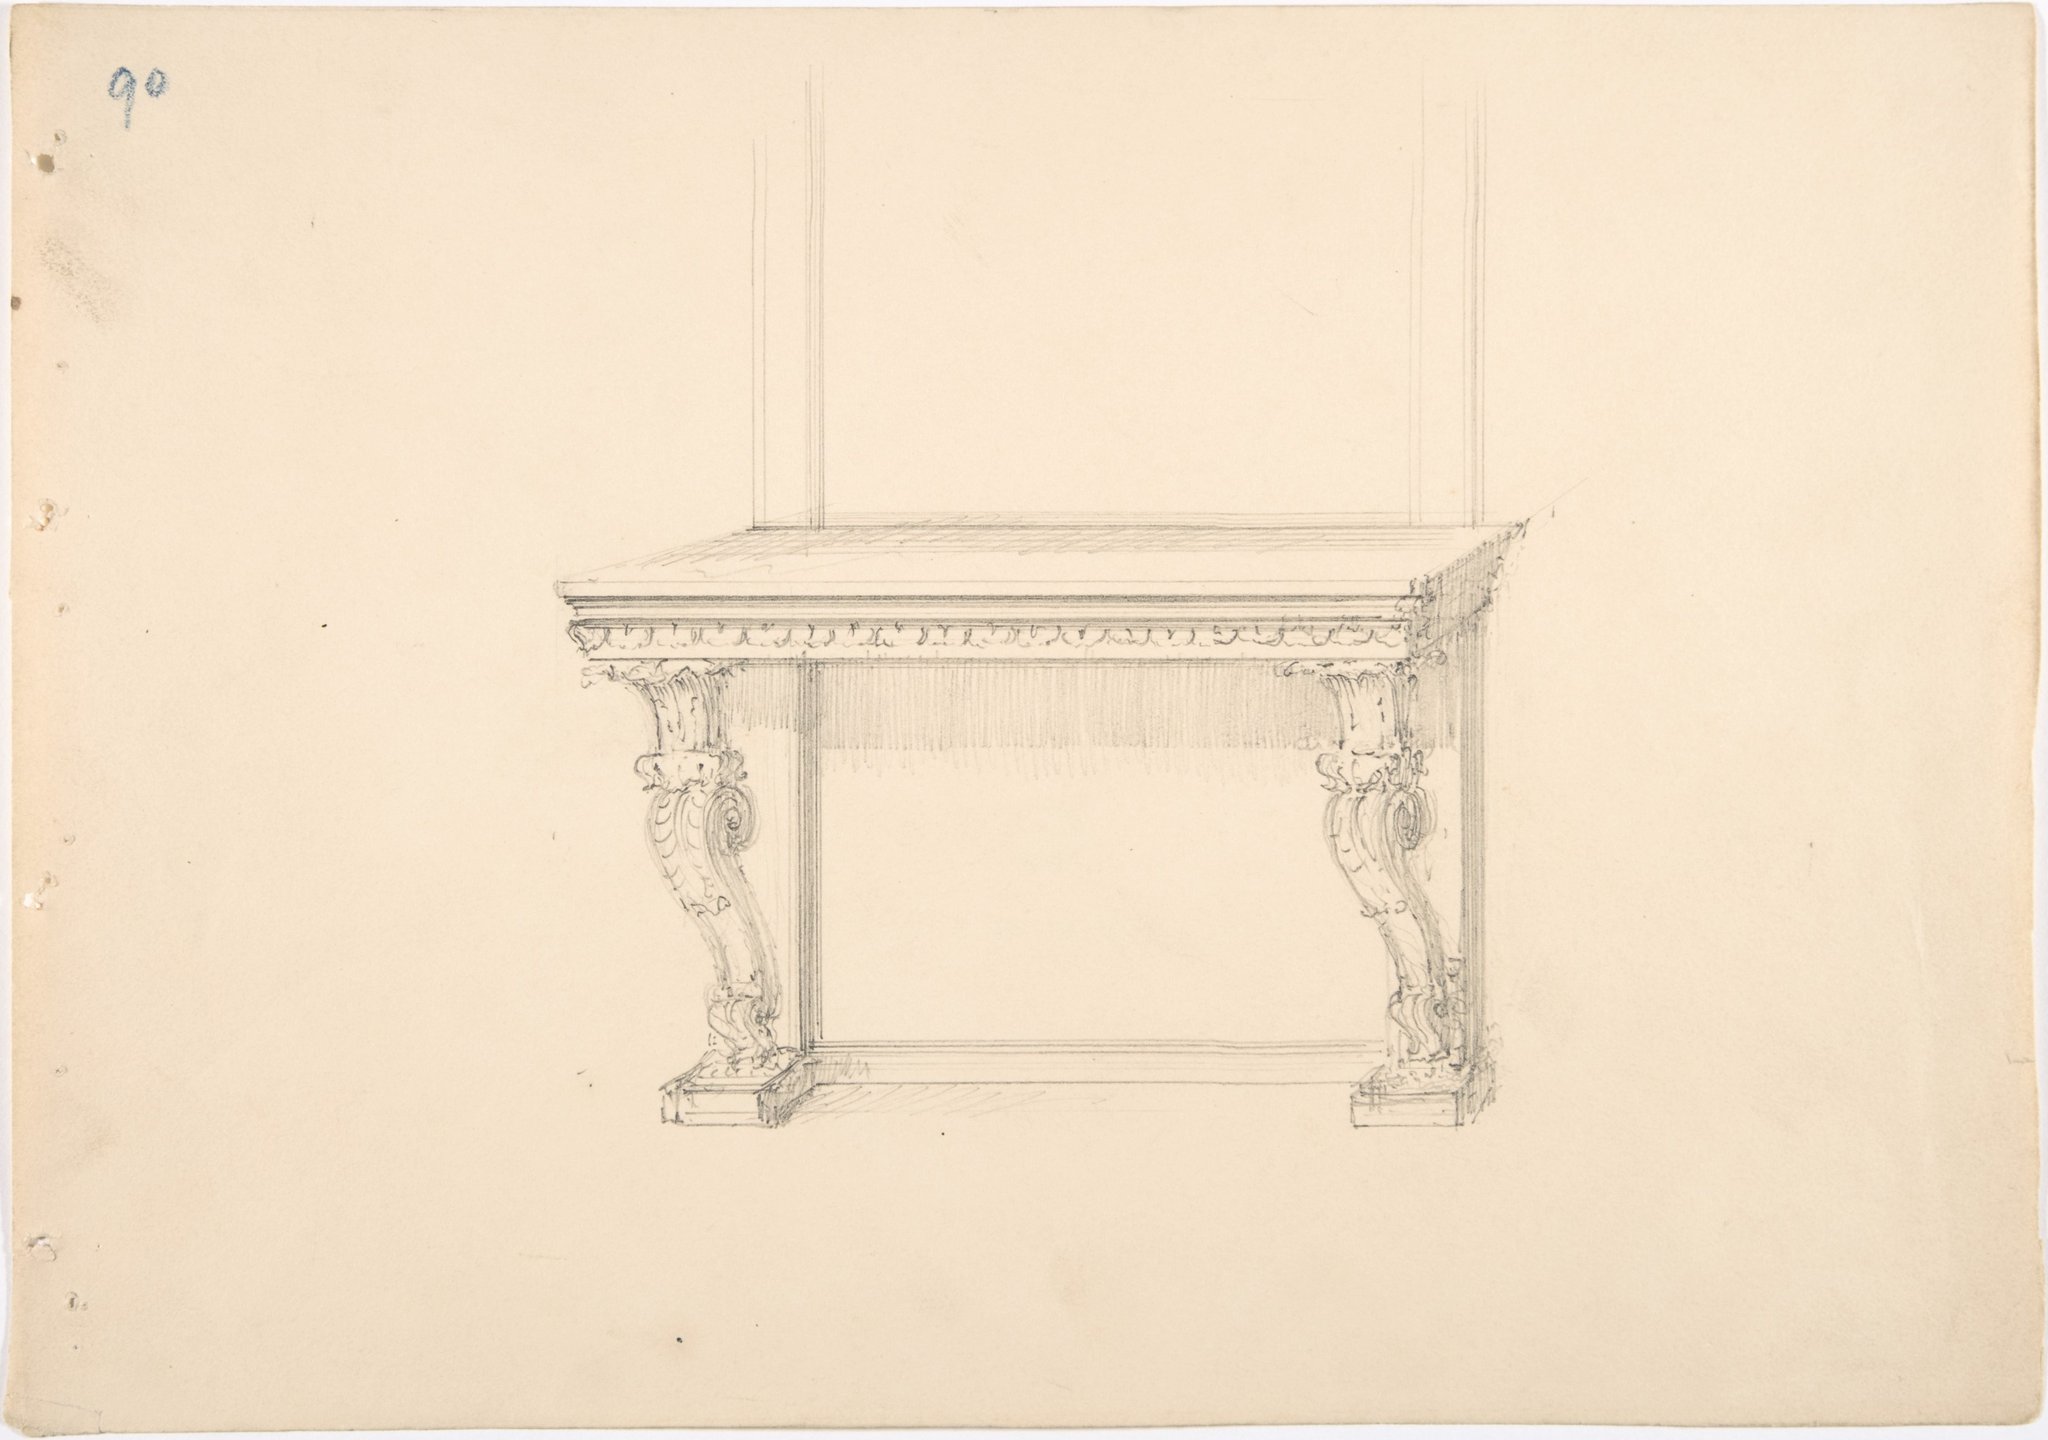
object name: drawing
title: Design for a Pier Table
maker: anonymous, british, 19th century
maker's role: artist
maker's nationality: british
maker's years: 1800-1900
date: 1801-1833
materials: graphite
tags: tables